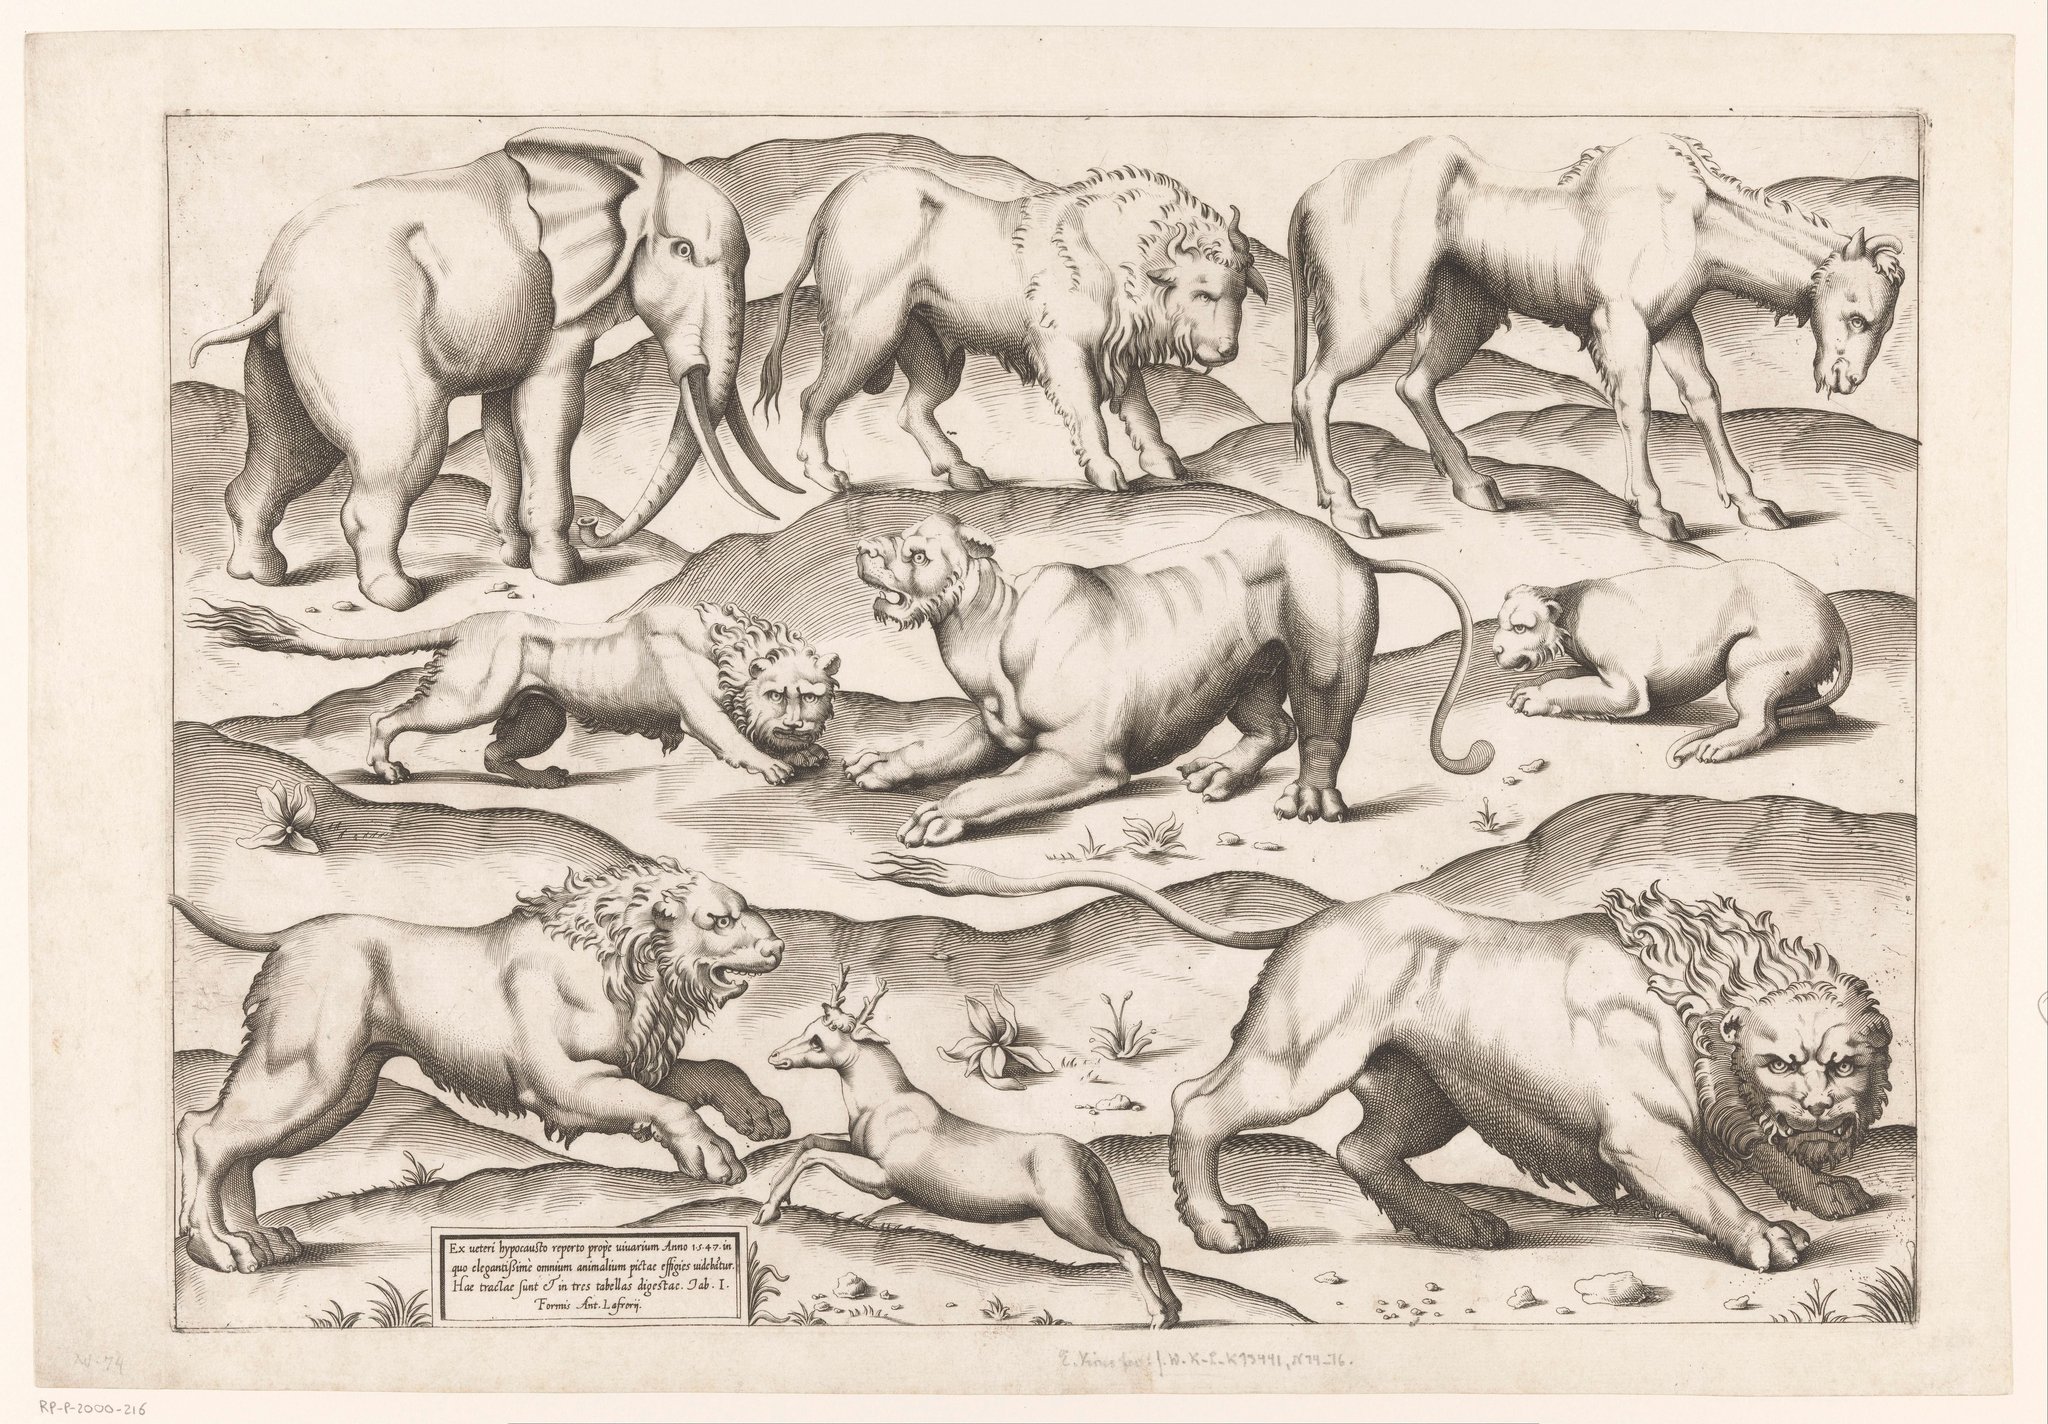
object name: print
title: Speculum Romanae Magnificentiae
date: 1547-1577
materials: paper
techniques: engraving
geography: rome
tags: mammals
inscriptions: collector's mark: Lugt 2228, collector's mark: Lugt 2760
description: Prent uit een reeks van drie prenten met voorstellingen van dieren. Volgens het opschrift op deze prent werden de prenten vervaardigd naar in 1547 ontdekte schilderingen in een hypocaustum. Deze prent behoort tot het prentcorpus dat bekend staat als de ‘Speculum Romanae Magnificentiae’ (‘Spiegel van Romeinse pracht’). Dit corpus, bestaande uit prenten met voorstellingen van kunstwerken en gebouwen uit het antieke en het moderne Rome, vond zijn oorsprong bij uitgevers Antonio Salamanca en Antonio Lafreri. Deze twee buitenlandse uitgevers bundelden hun krachten te Rome in de periode 1553-1563. Hun prenten werden al snel razend populair bij toeristen en verzamelaars, die de prenten individueel of in grote groepen aanschaften. Grote groepen Speculum-prenten werden vaak op aanvraag samengebonden in albums. Er zijn verschillende Speculum-albums overgeleverd die allemaal verschillen van inhoud. Tussen 1573 en 1577 gaf Antonio Lafreri een speciale titelpagina uit (met de titel ‘Speculum Romanae Magnificentiae’) die mensen voor hun verzamelingen konden voegen. Het overlijden van Lafreri in 1577 betekende niet het einde van het corpus. Een groot deel van de koperplaten ging over op Claudio en Stefano Duchetti. De rest raakte verspreid over verschillende andere uitgevers. De populariteit van de Speculum-prenten wist nog geruime periode uitgevers te inspireren tot het laten maken van kopieën en het toevoegen van nieuwe prenten aan het corpus.